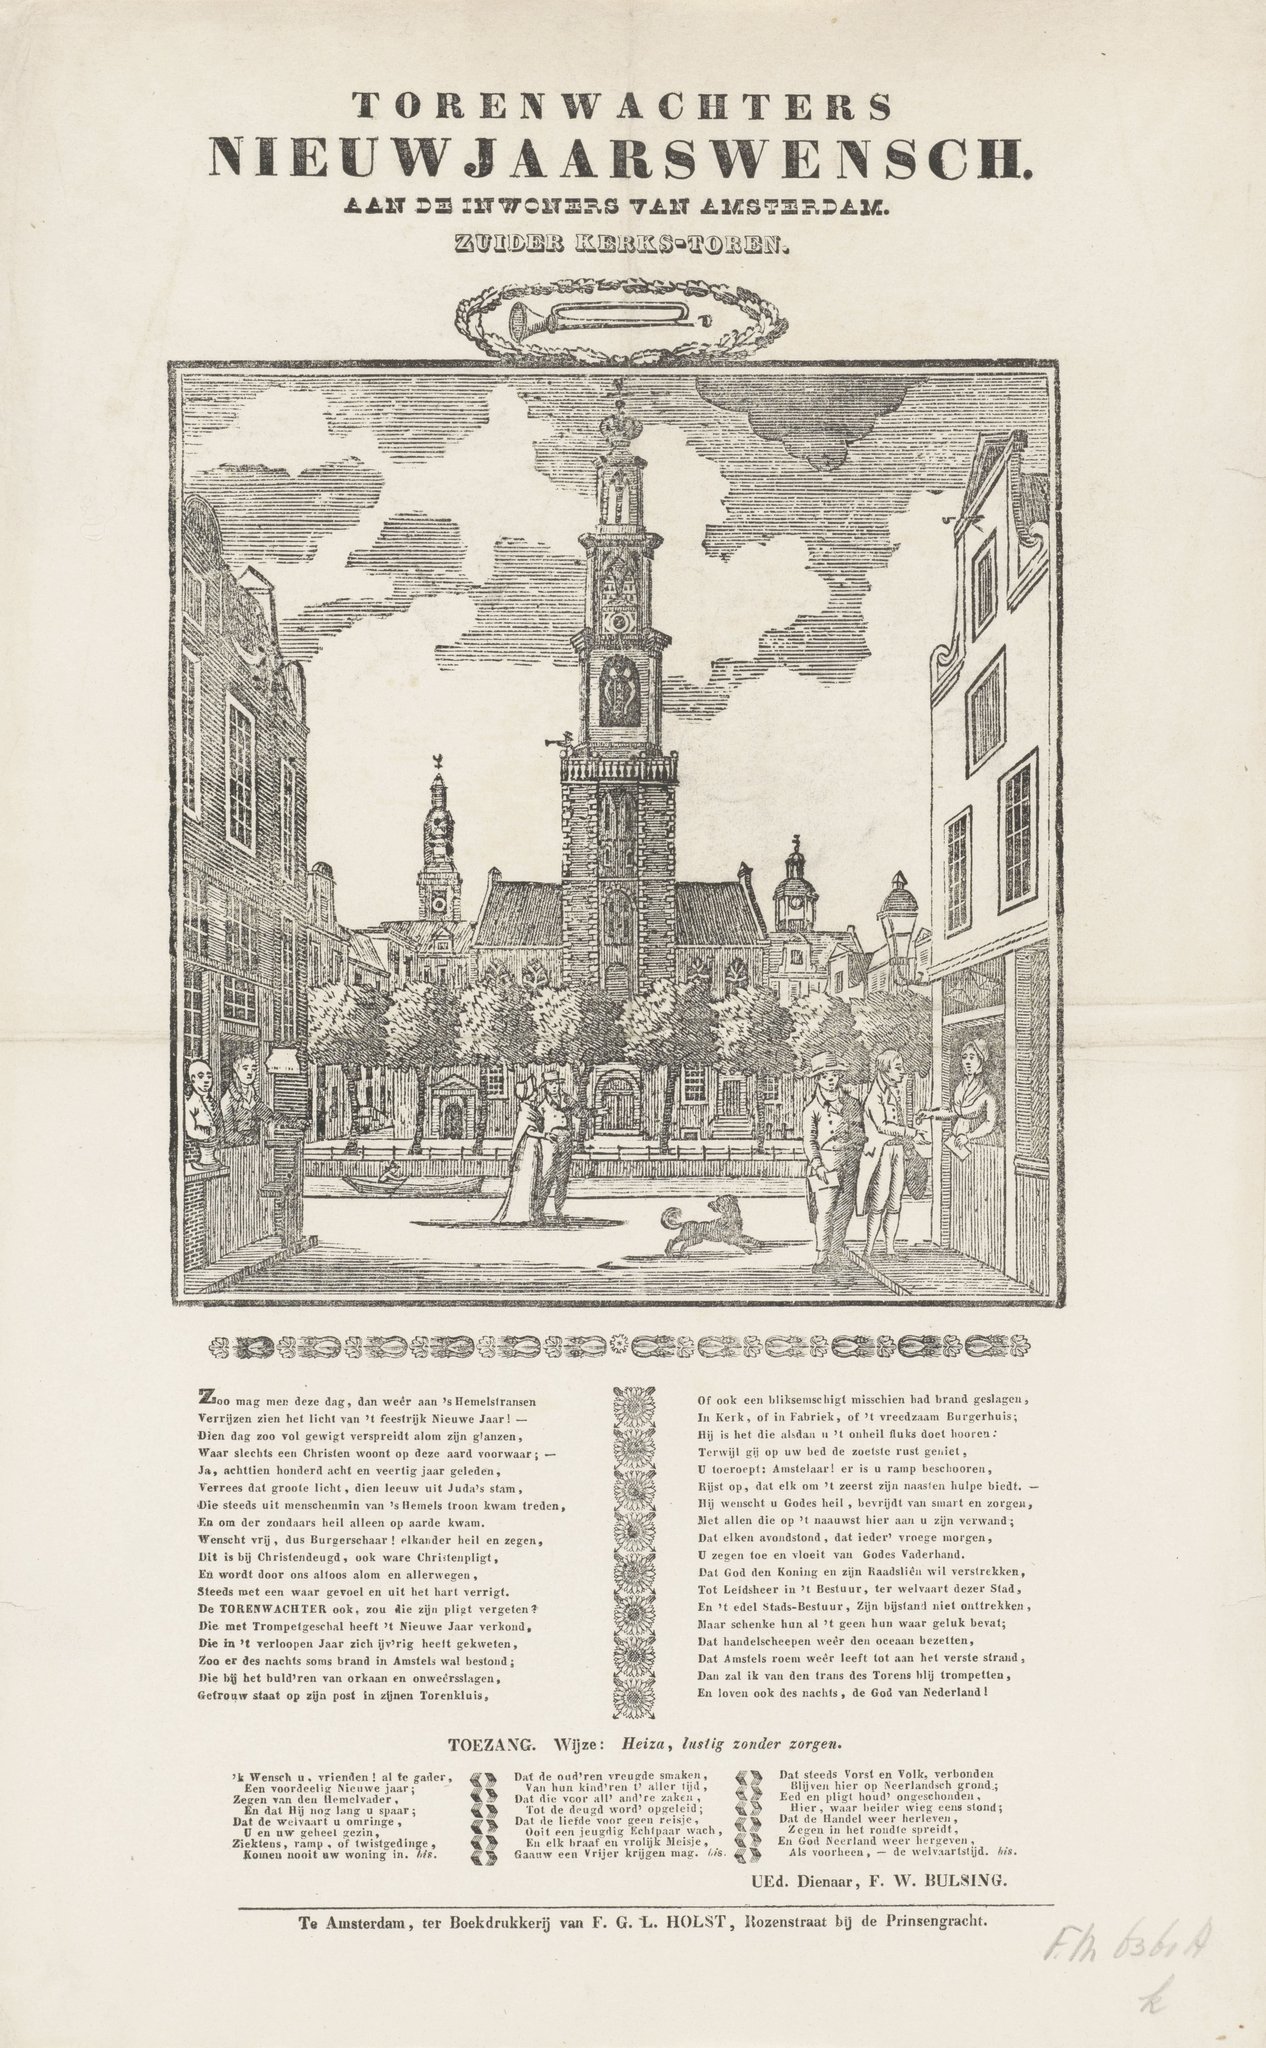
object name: new year card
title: Nieuwjaarswens van de torenwachters van de Zuiderkerk te Amsterdam, ca. 1840-1870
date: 1840-1870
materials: paper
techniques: letterpress printing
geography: amsterdam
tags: tower sentry, street, amsterdam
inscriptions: collector's mark: Lugt 2228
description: Nieuwjaarswens van de torenwachter van de Amsterdamse Zuiderkerk, ca. 1840-1870. Gezicht op de Westerkerk te Amsterdam, twee mannen halen aan de huizen geld op. Onderaan een gedicht in twee kolommen en een lied in drie verzen. Van de torenwachter: F.W. Bulsing.